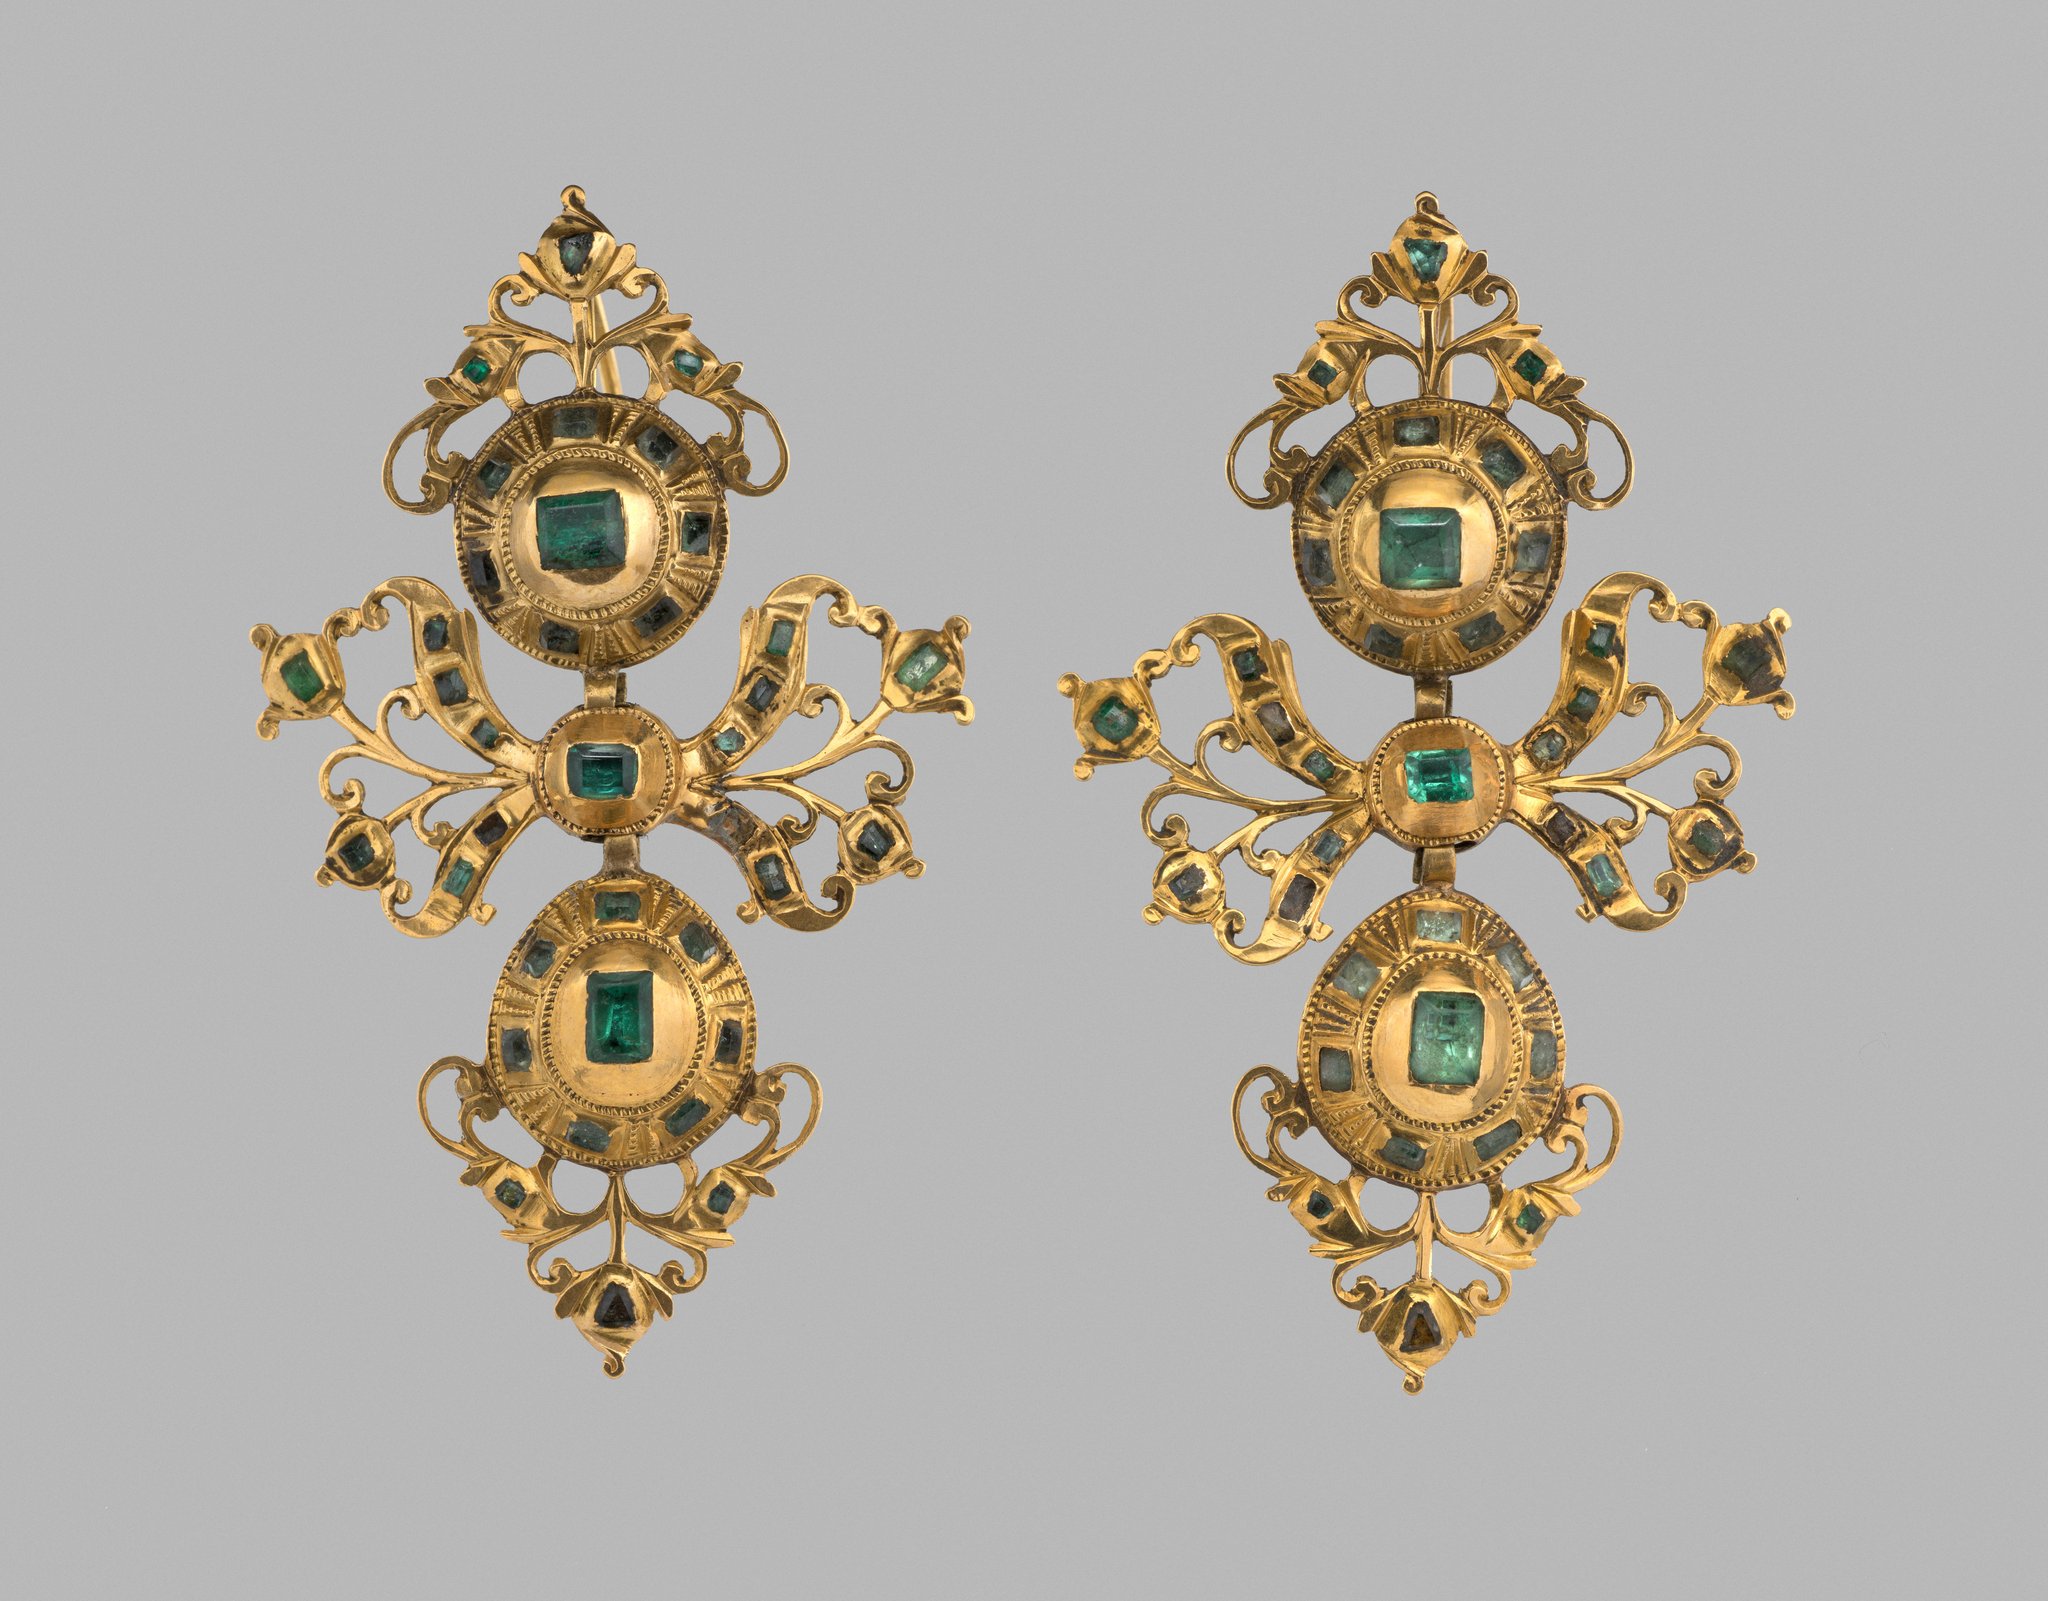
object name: earring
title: Pair of earrings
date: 1701-1800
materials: gemstone, gold